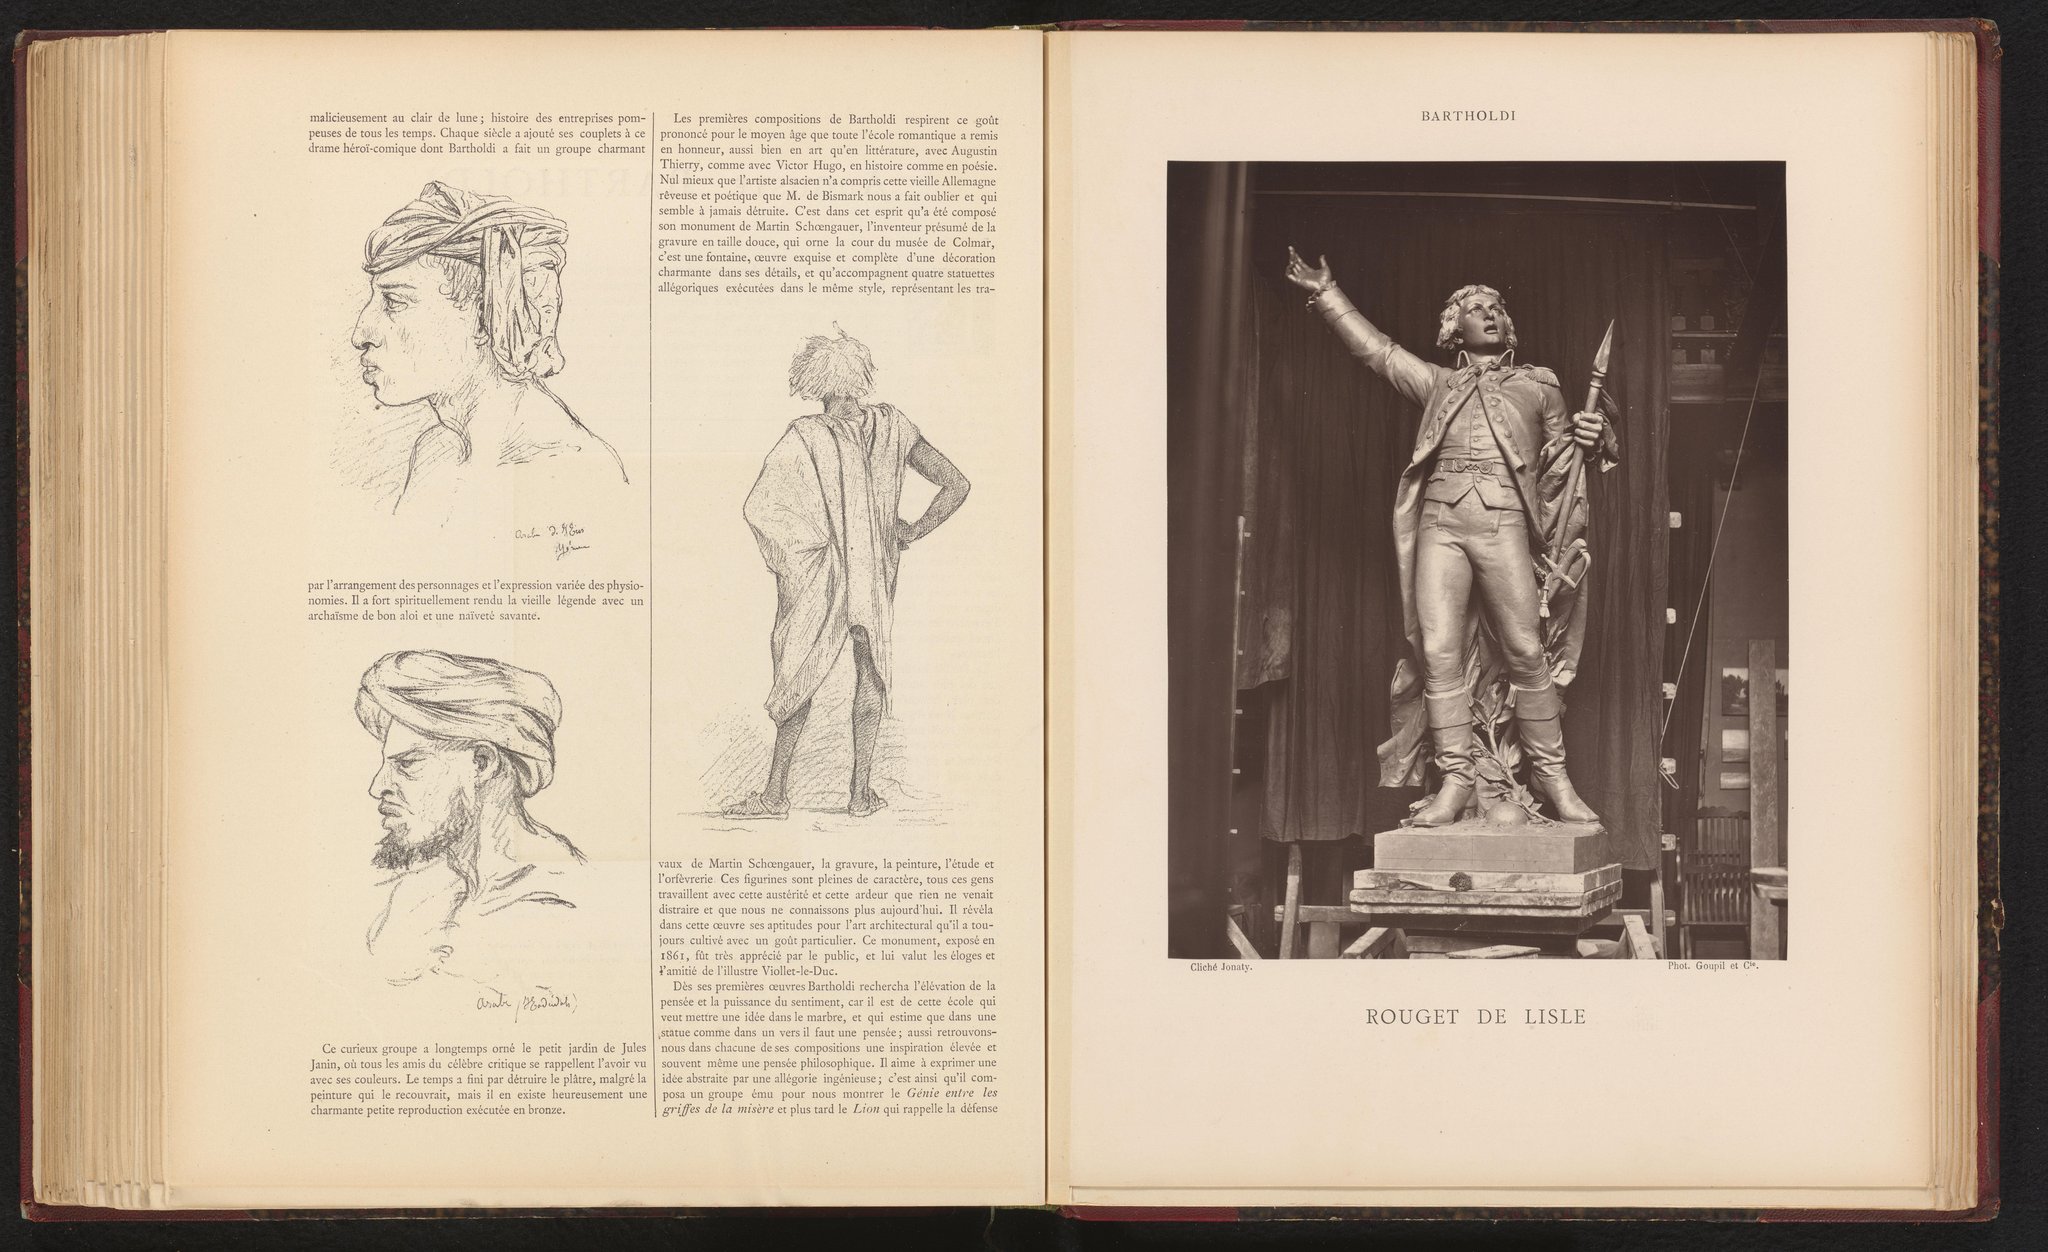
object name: page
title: Rouget de Lisle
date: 1878-1883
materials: paper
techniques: woodburytype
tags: sculpture